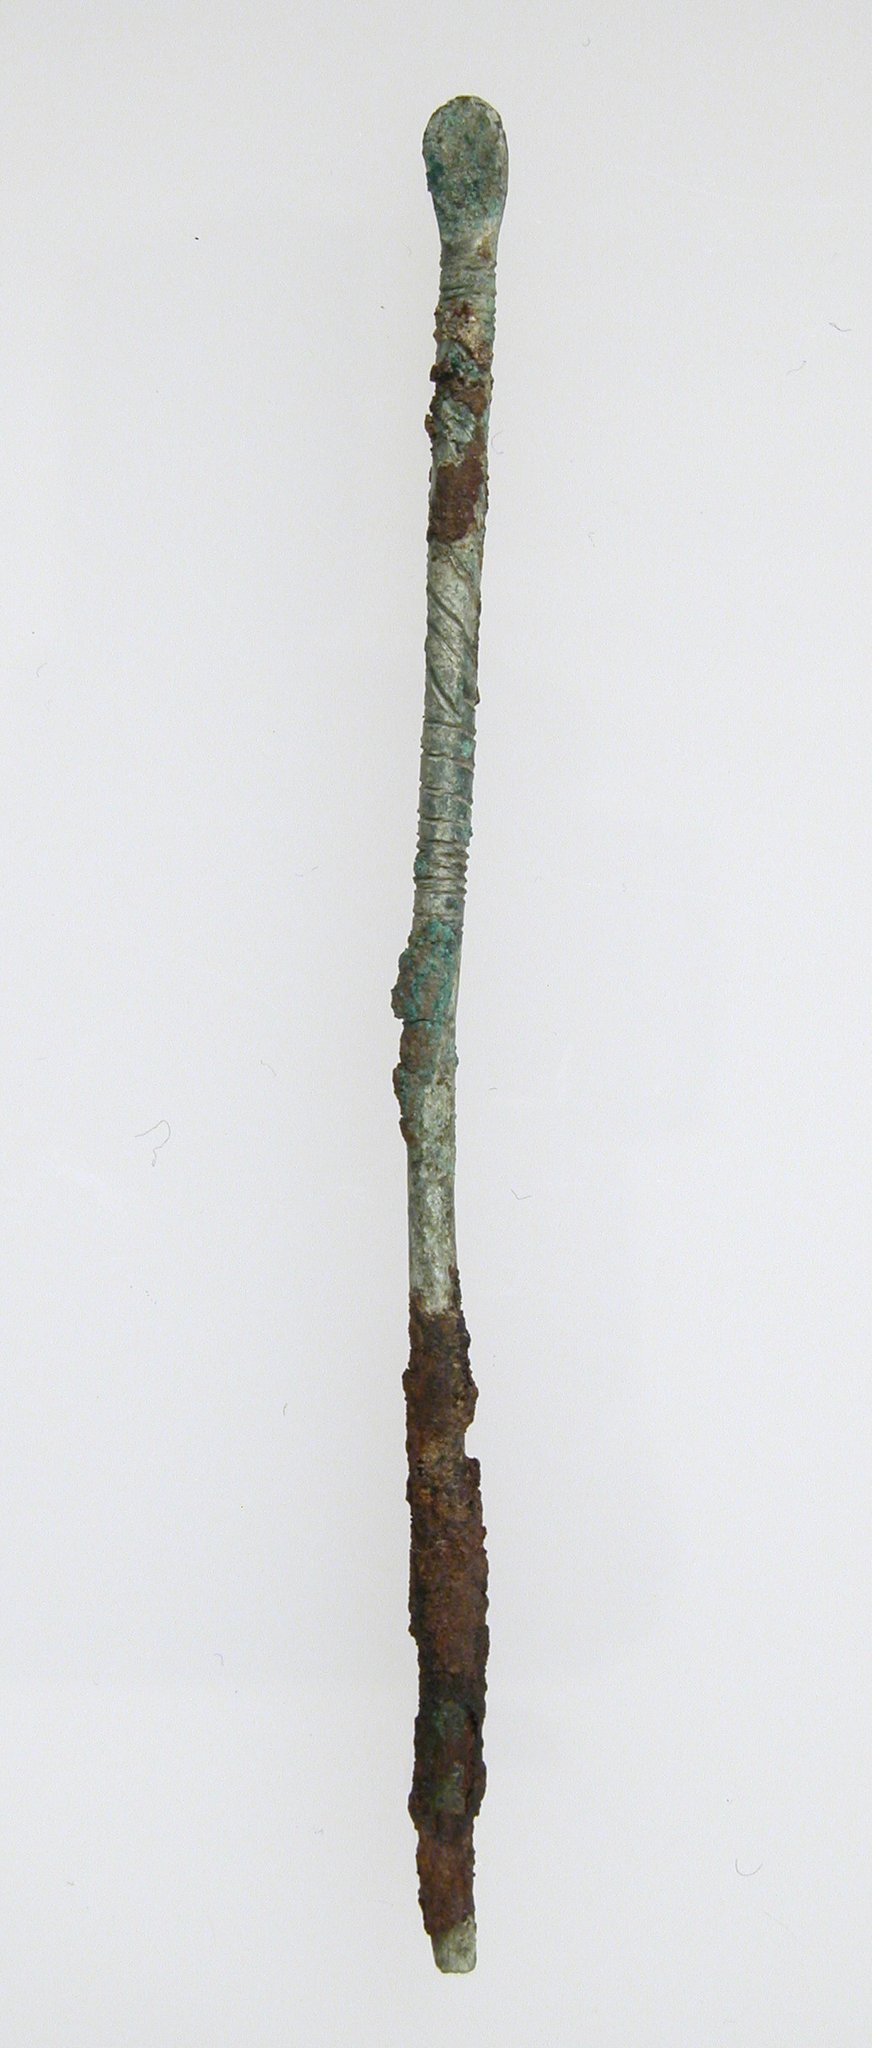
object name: hairpin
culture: frankish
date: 500-600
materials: copper alloy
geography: germany